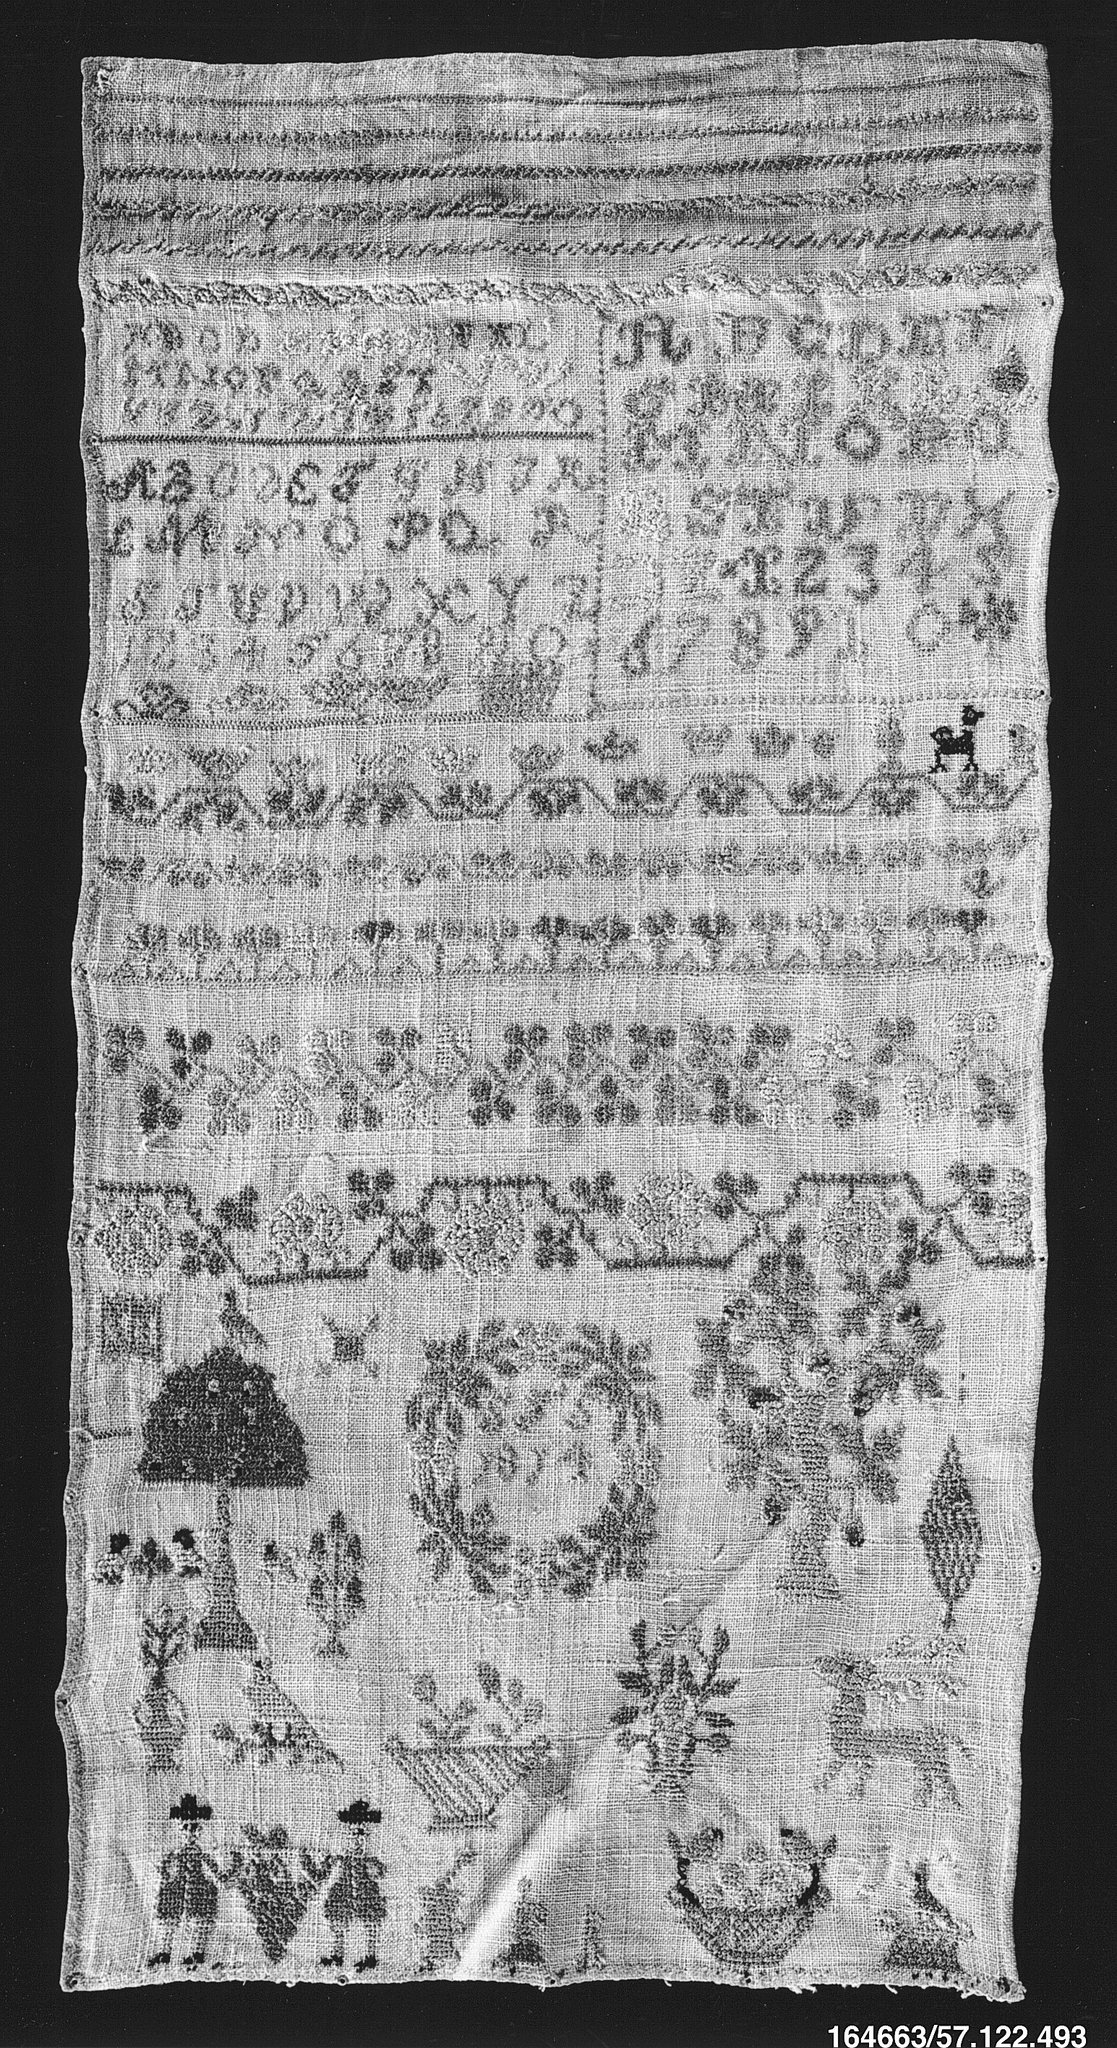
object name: sampler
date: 1814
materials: linen, silk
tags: birds,deer,trees